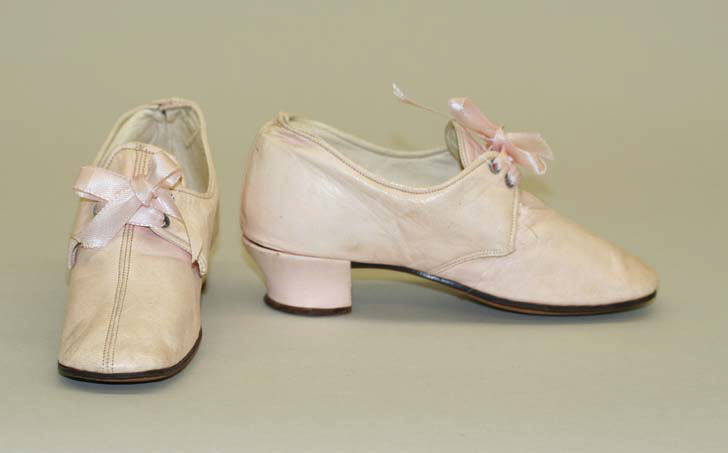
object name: shoe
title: Shoes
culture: american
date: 1880-1885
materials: leather